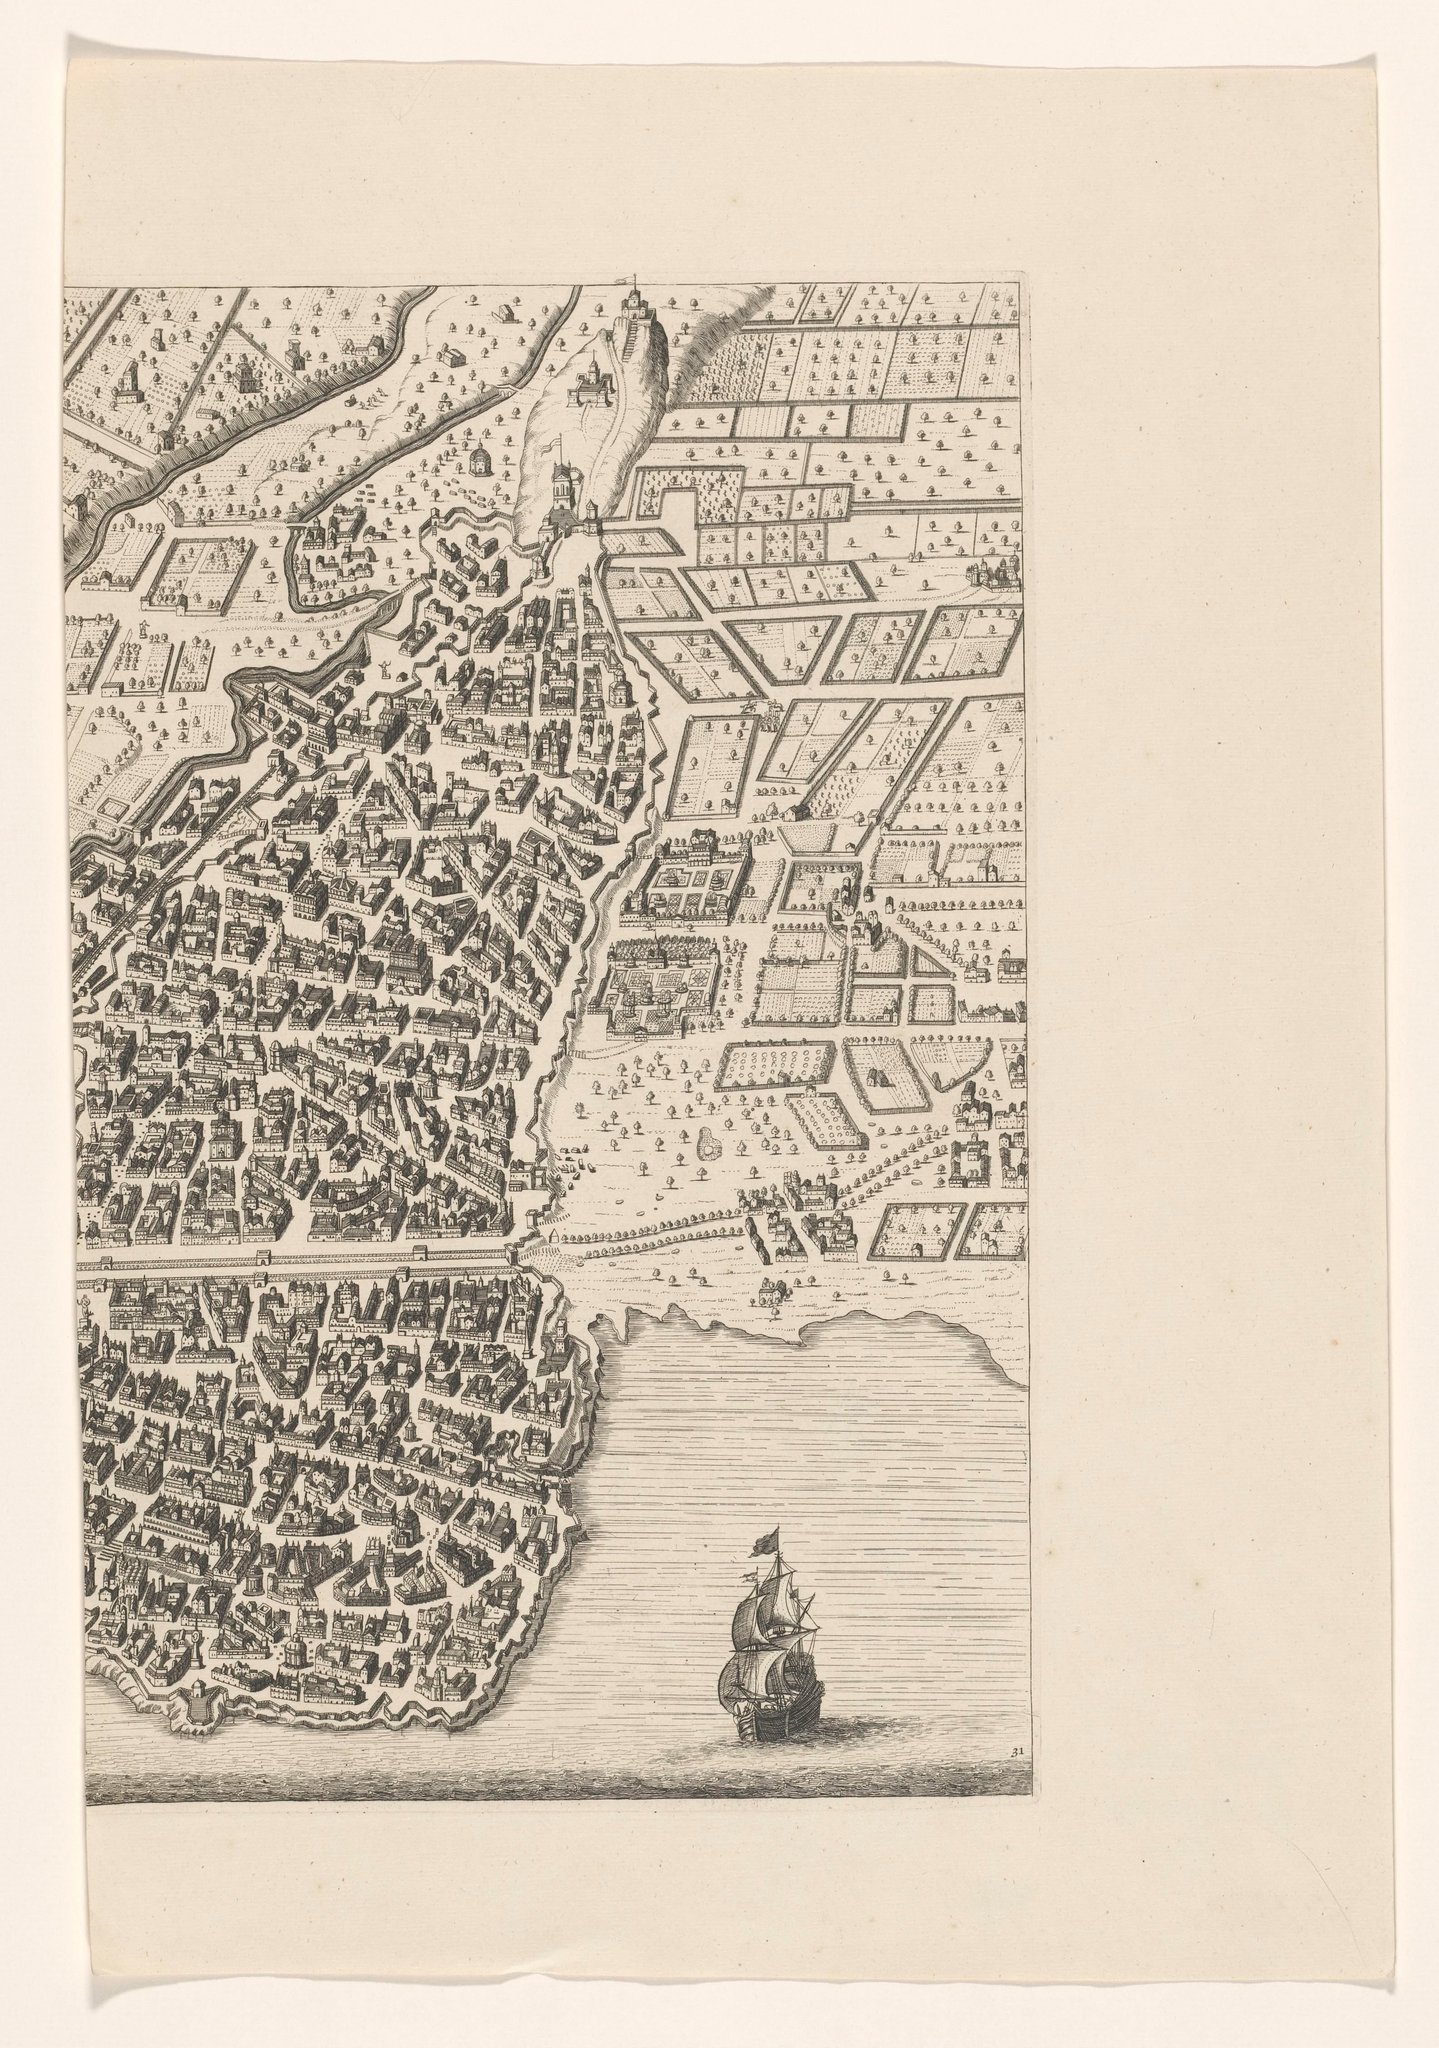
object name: area plan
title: Plattegrond van een Italiaanse stad (rechterdeel)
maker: Anonymous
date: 1600-1699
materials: paper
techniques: engraving, etching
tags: maps of cities, italy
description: Rechterdeel van een plattegrond van een Italiaanse stad, gesneden in twee delen. Rechtsonder genummerd: 31.